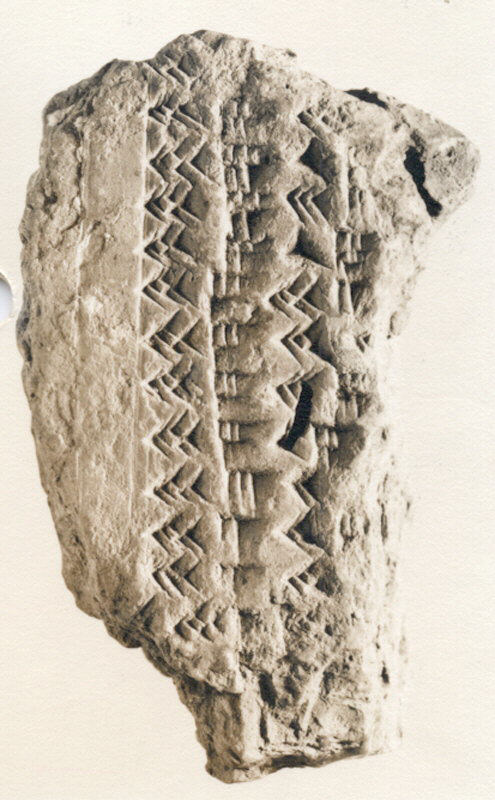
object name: cuneiform tablet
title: Cuneiform tablet: fragment of a table of reciprocals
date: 333-1 BCE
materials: clay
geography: mesopotamia